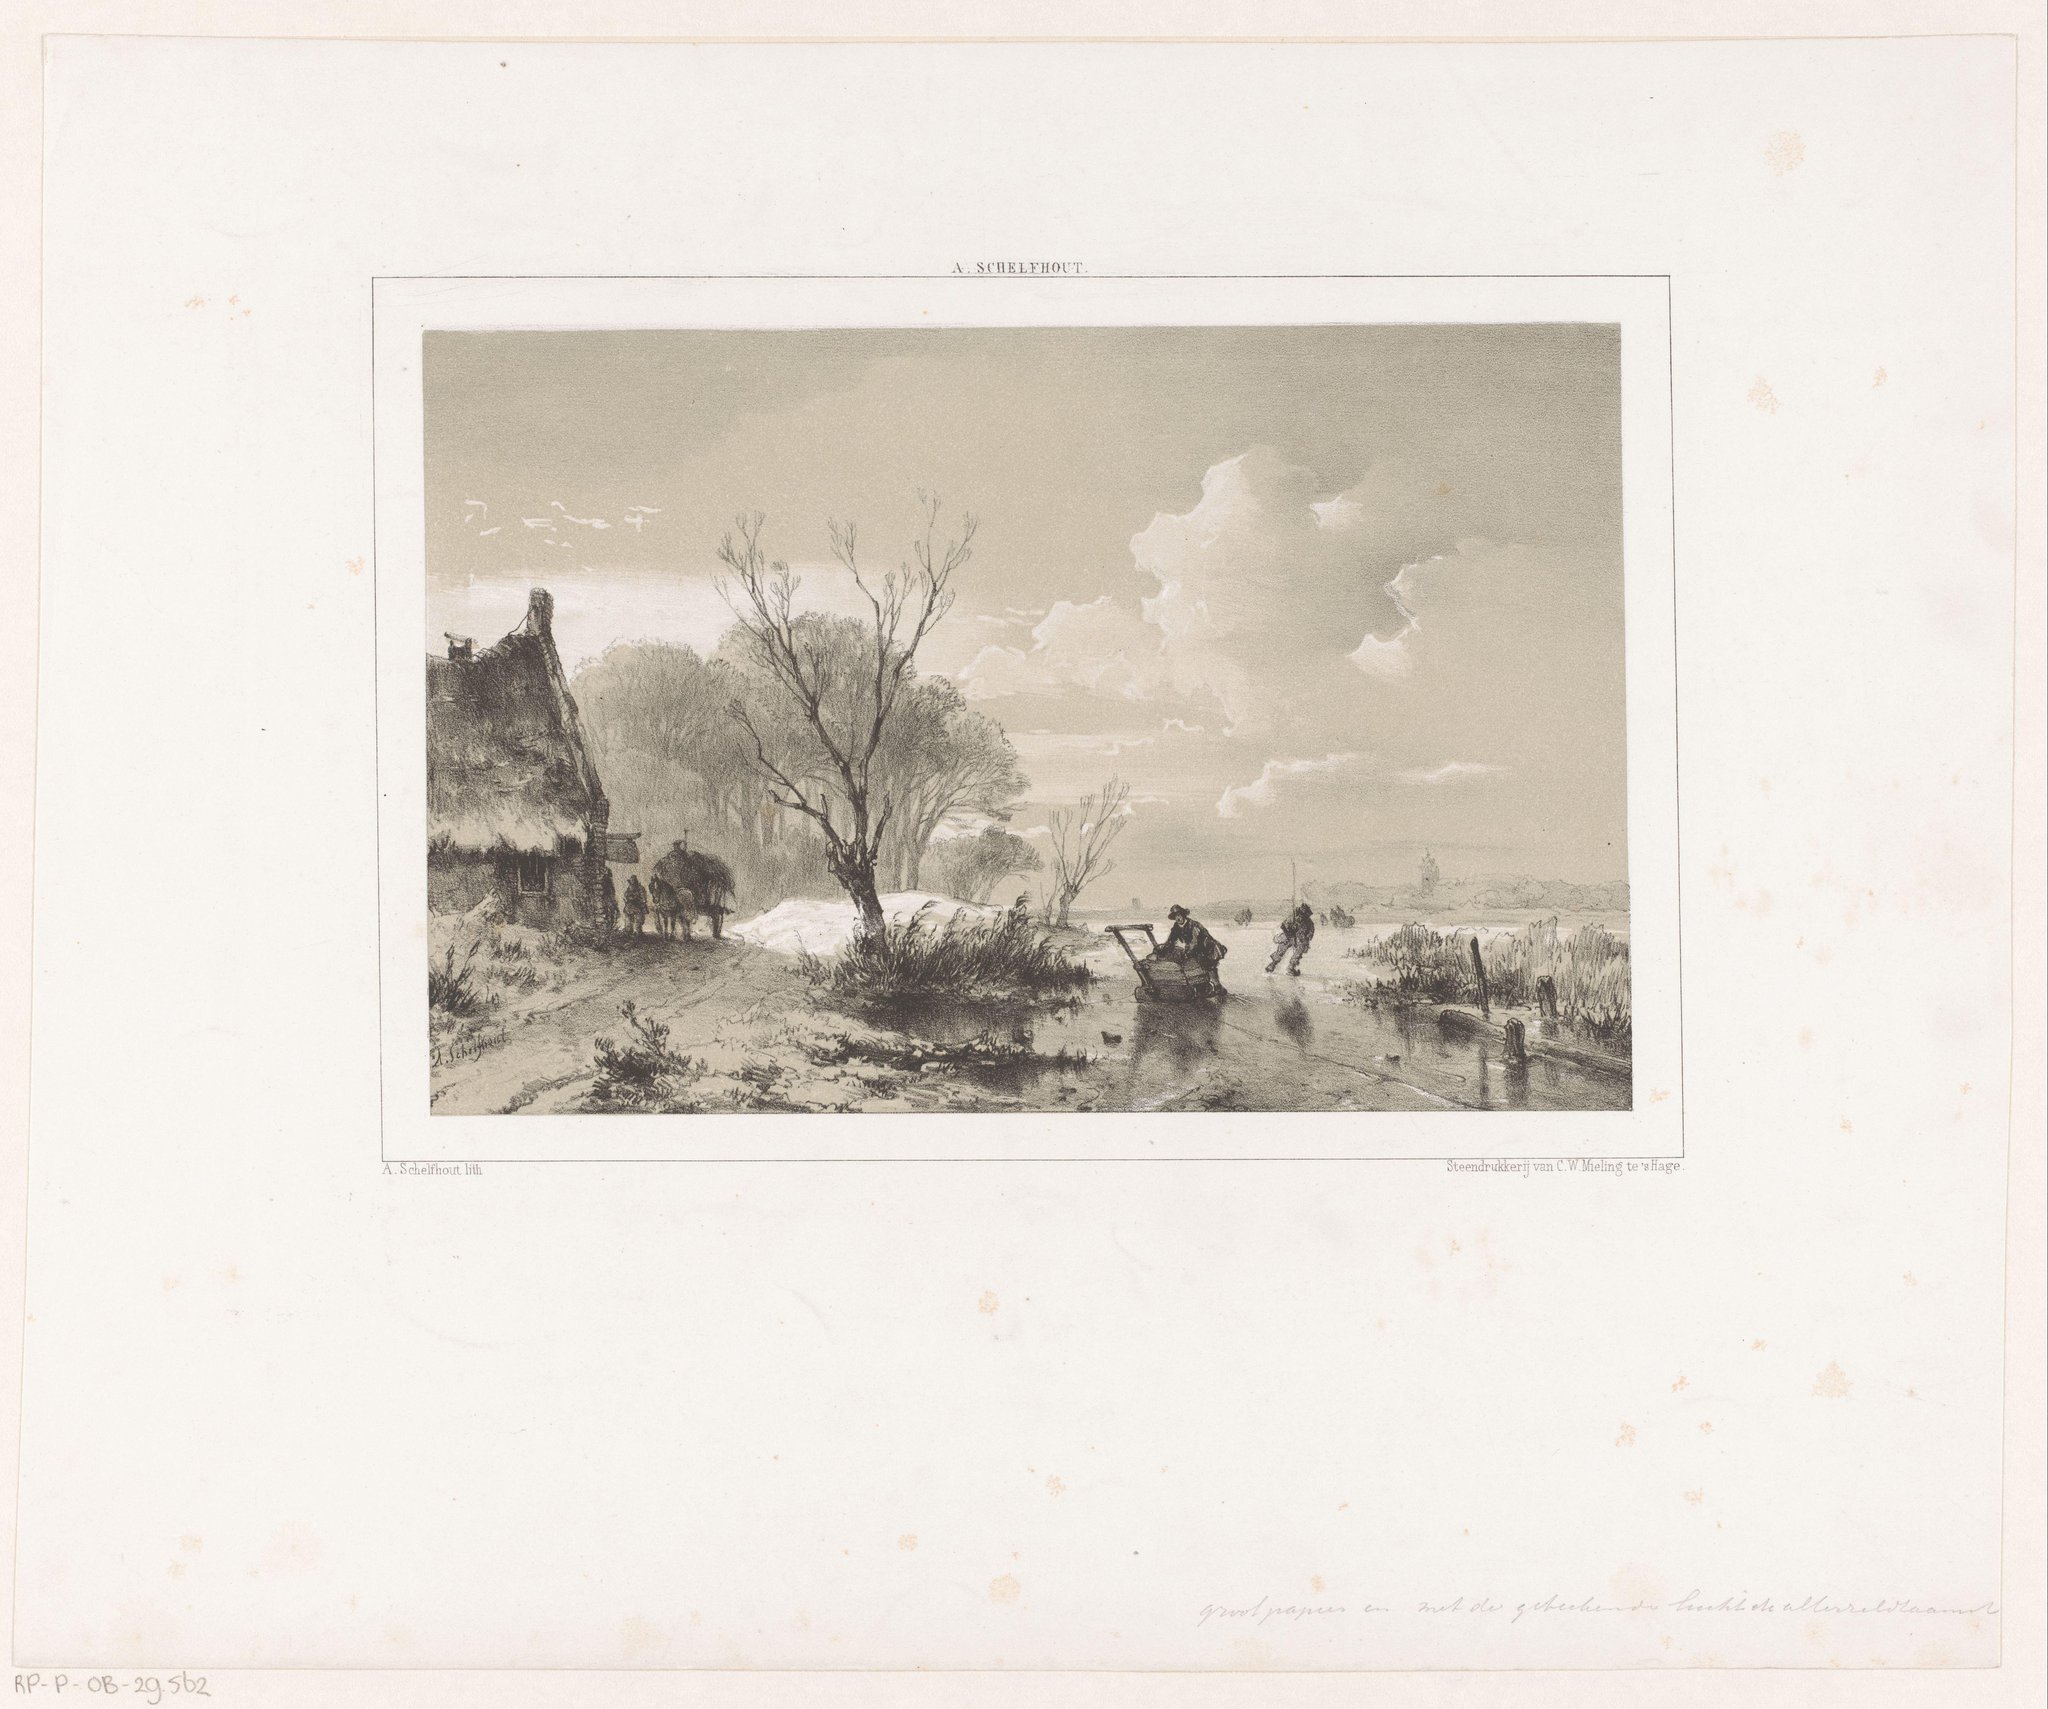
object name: print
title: Schaatsers en man met slee op bevroren rivier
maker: andreas schelfhout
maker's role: draughtsman, painter, print maker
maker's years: 1787-1870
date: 1847-1865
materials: paper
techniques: tone lithography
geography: the hague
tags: river, skates (winter sports), sledge, sleigh (winter sports)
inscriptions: collector's mark: Lugt 2228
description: Op een bevroren rivier schaatsende figuren en een man achter een slee. Links staat een man met paard en wagen op een pad voor een huis.